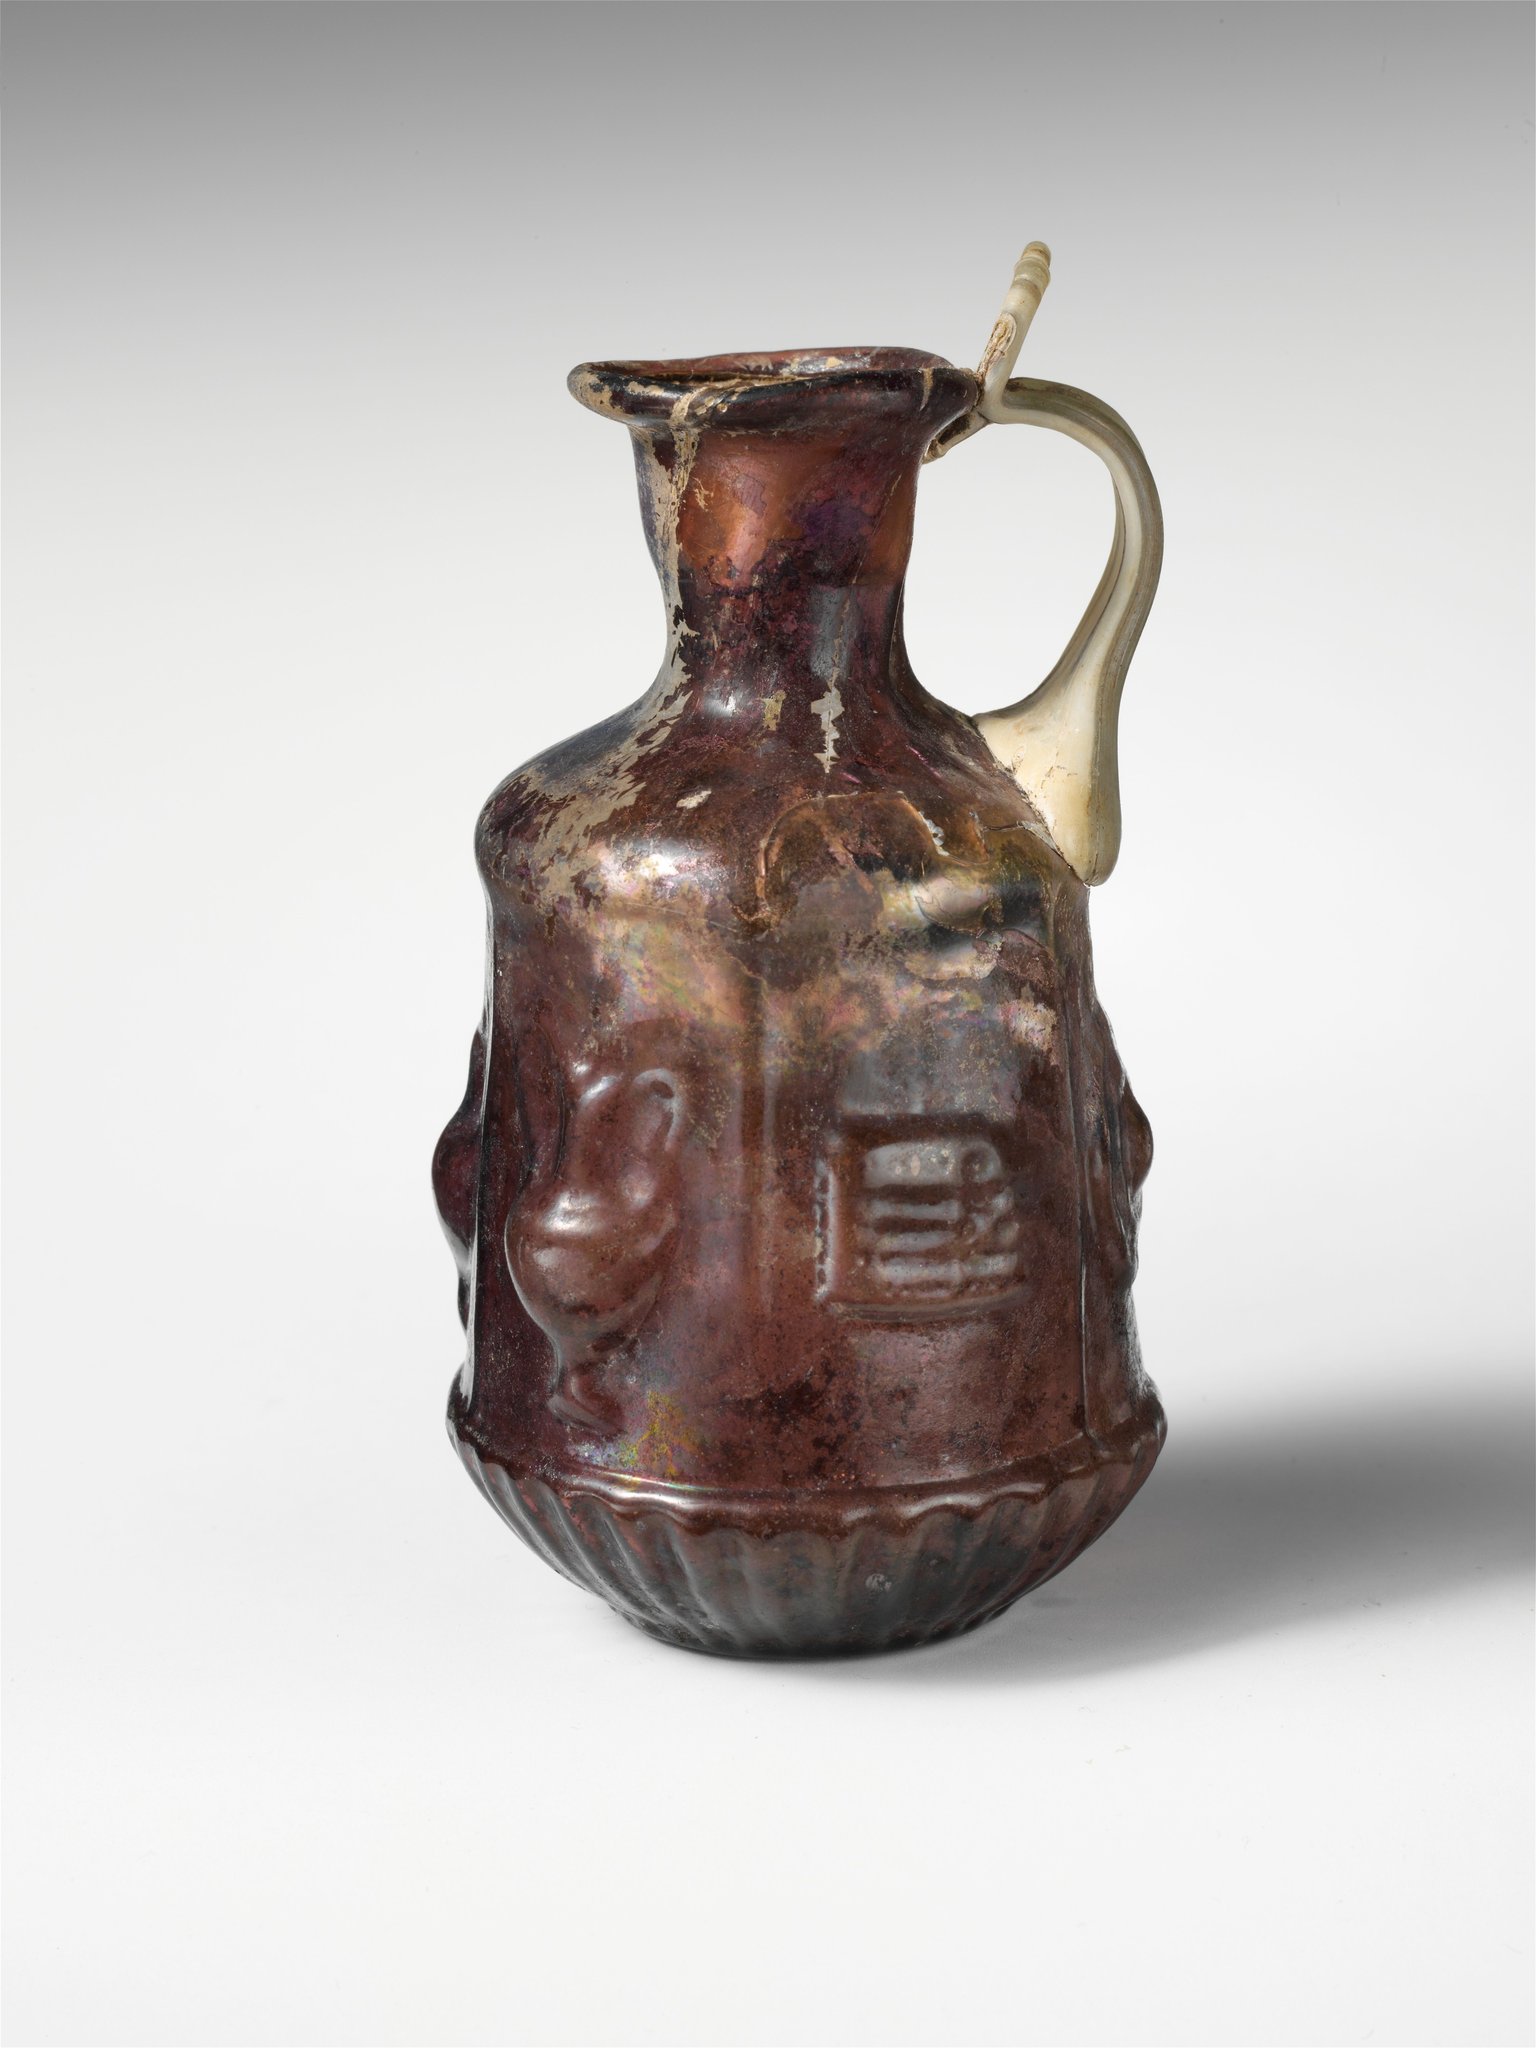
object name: jug, hexagonal, dionysiac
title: Glass hexagonal jug with Dionysiac symbols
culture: roman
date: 1-100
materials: glass